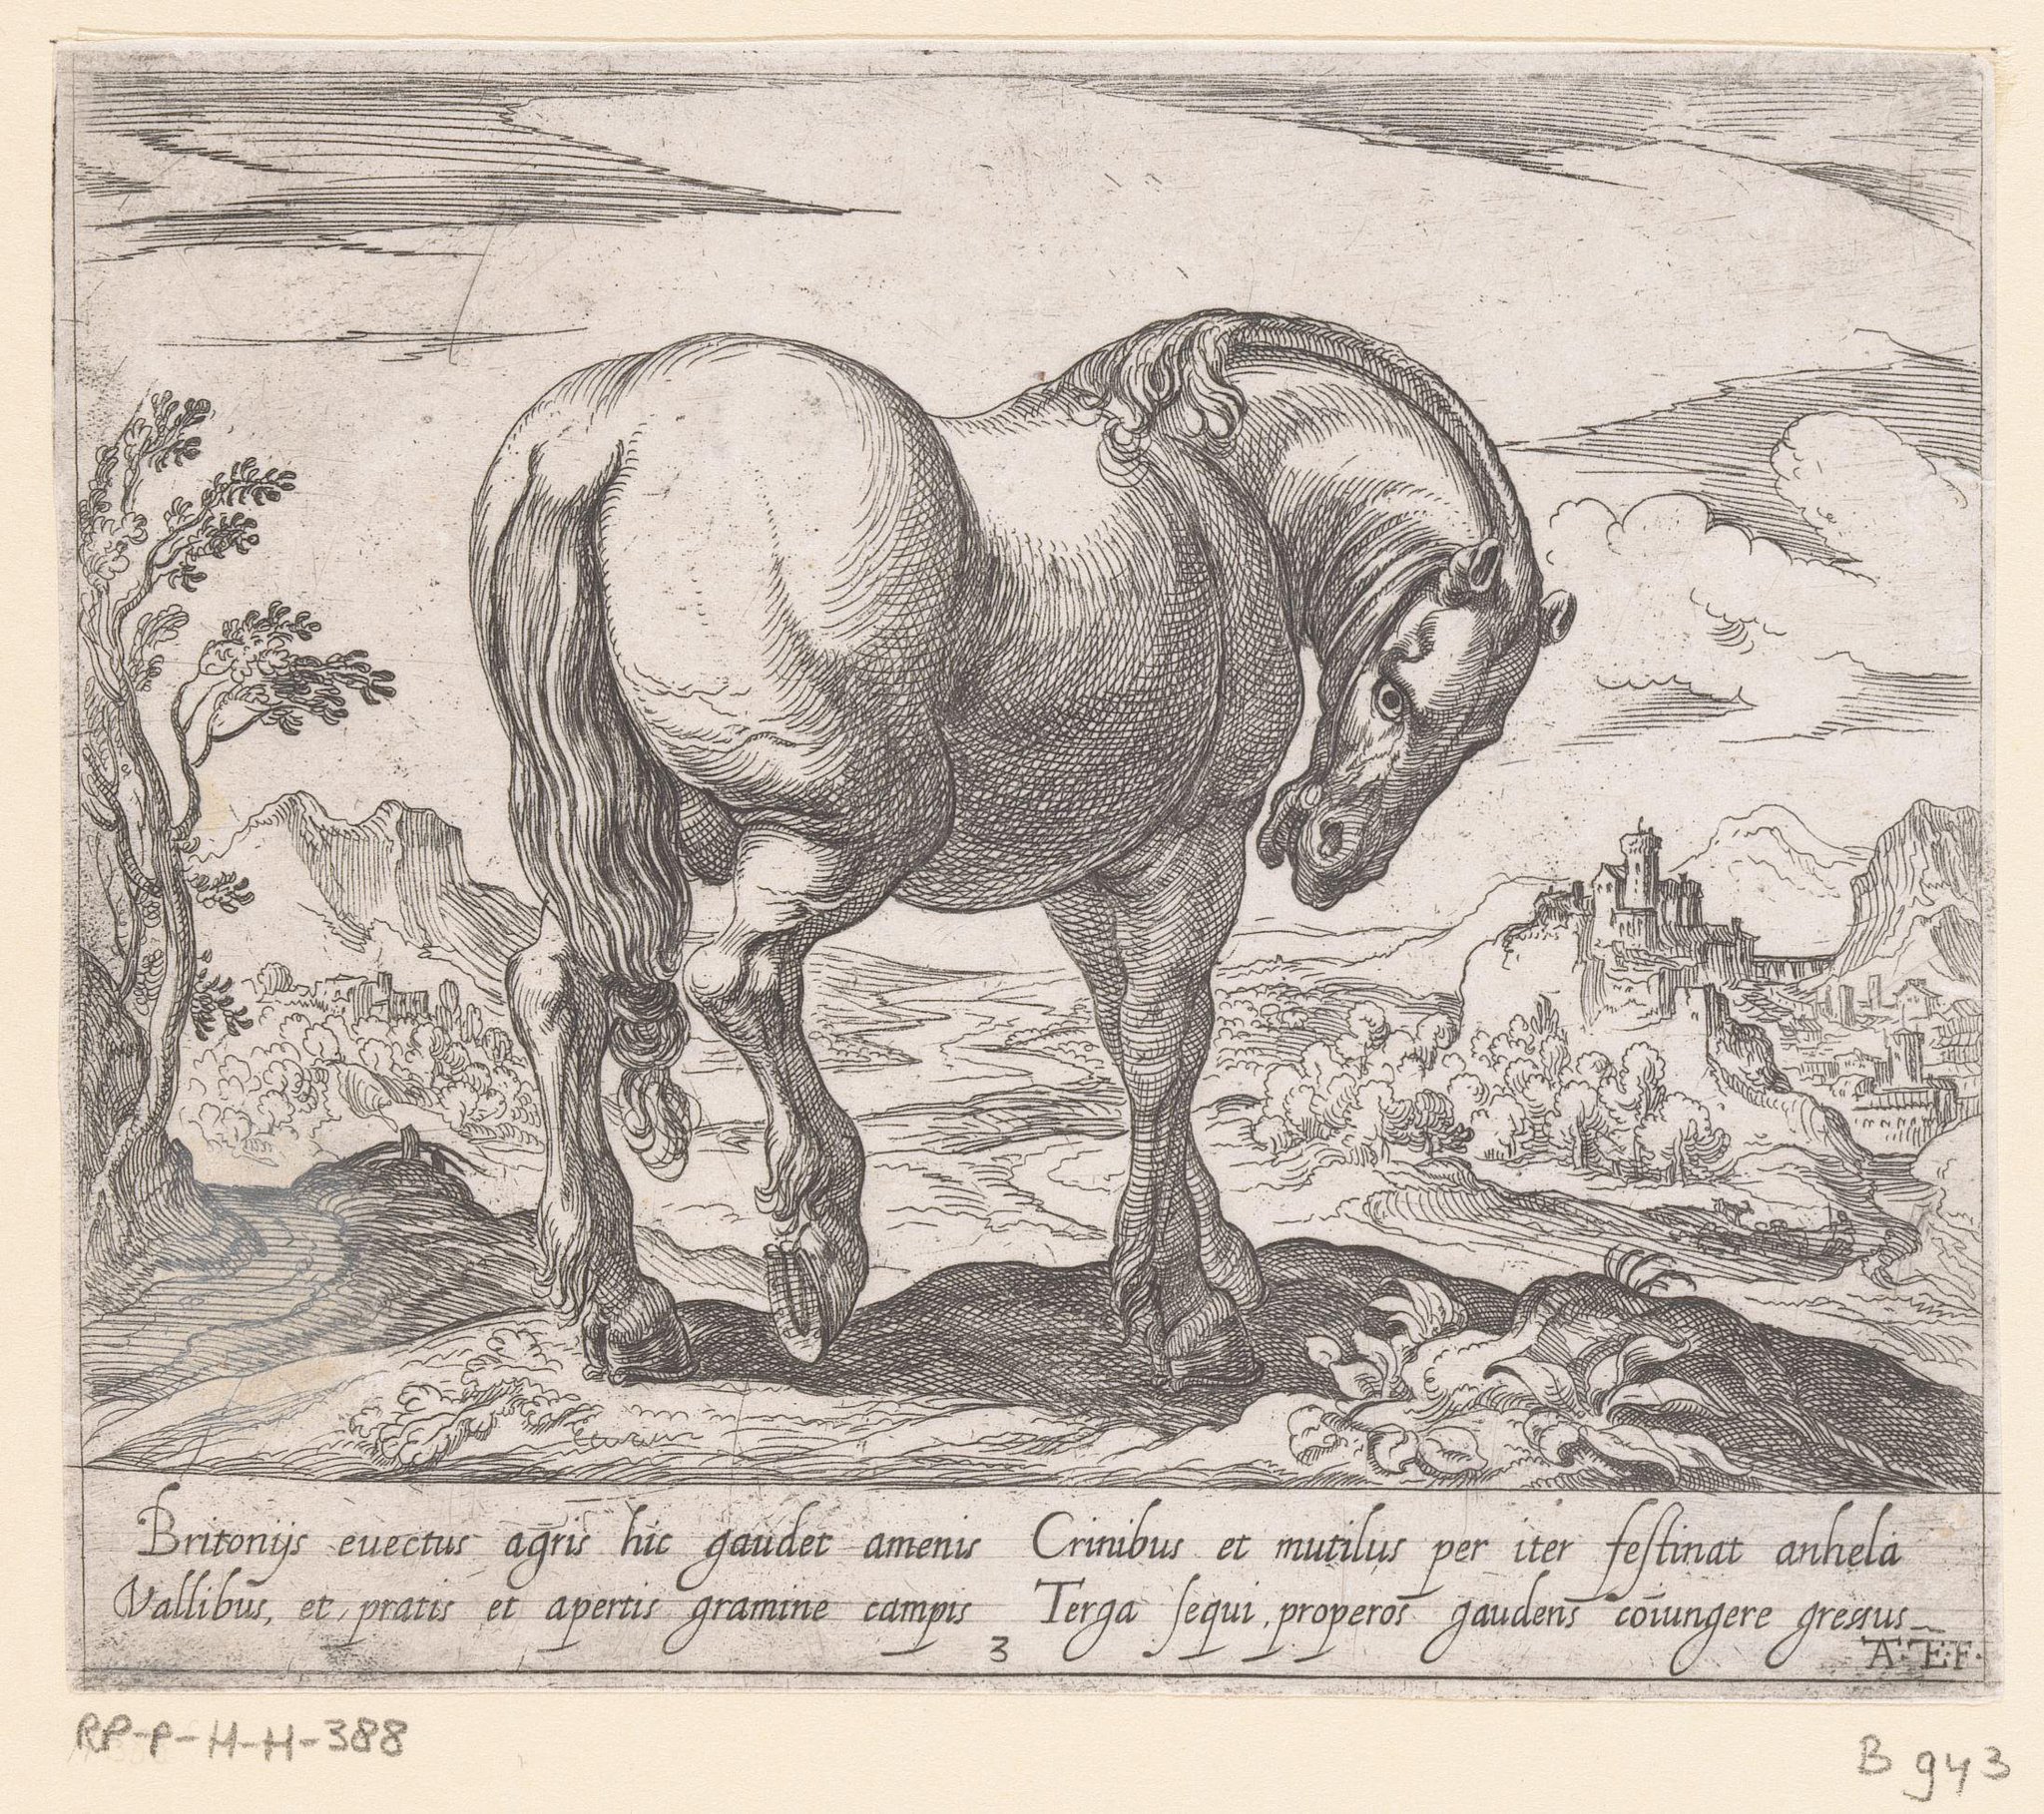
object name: print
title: Paarden uit verschillende landen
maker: antonio tempesta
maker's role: draughtsman, painter, print maker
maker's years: 1555-1630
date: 1590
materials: paper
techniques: etching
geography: italy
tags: horse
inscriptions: number: ‘3’, collector's mark: ‘Hinloopen’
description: Deze prent maakt deel uit van een reeks van 28 prenten van paarden (+ titelprent en opdracht).